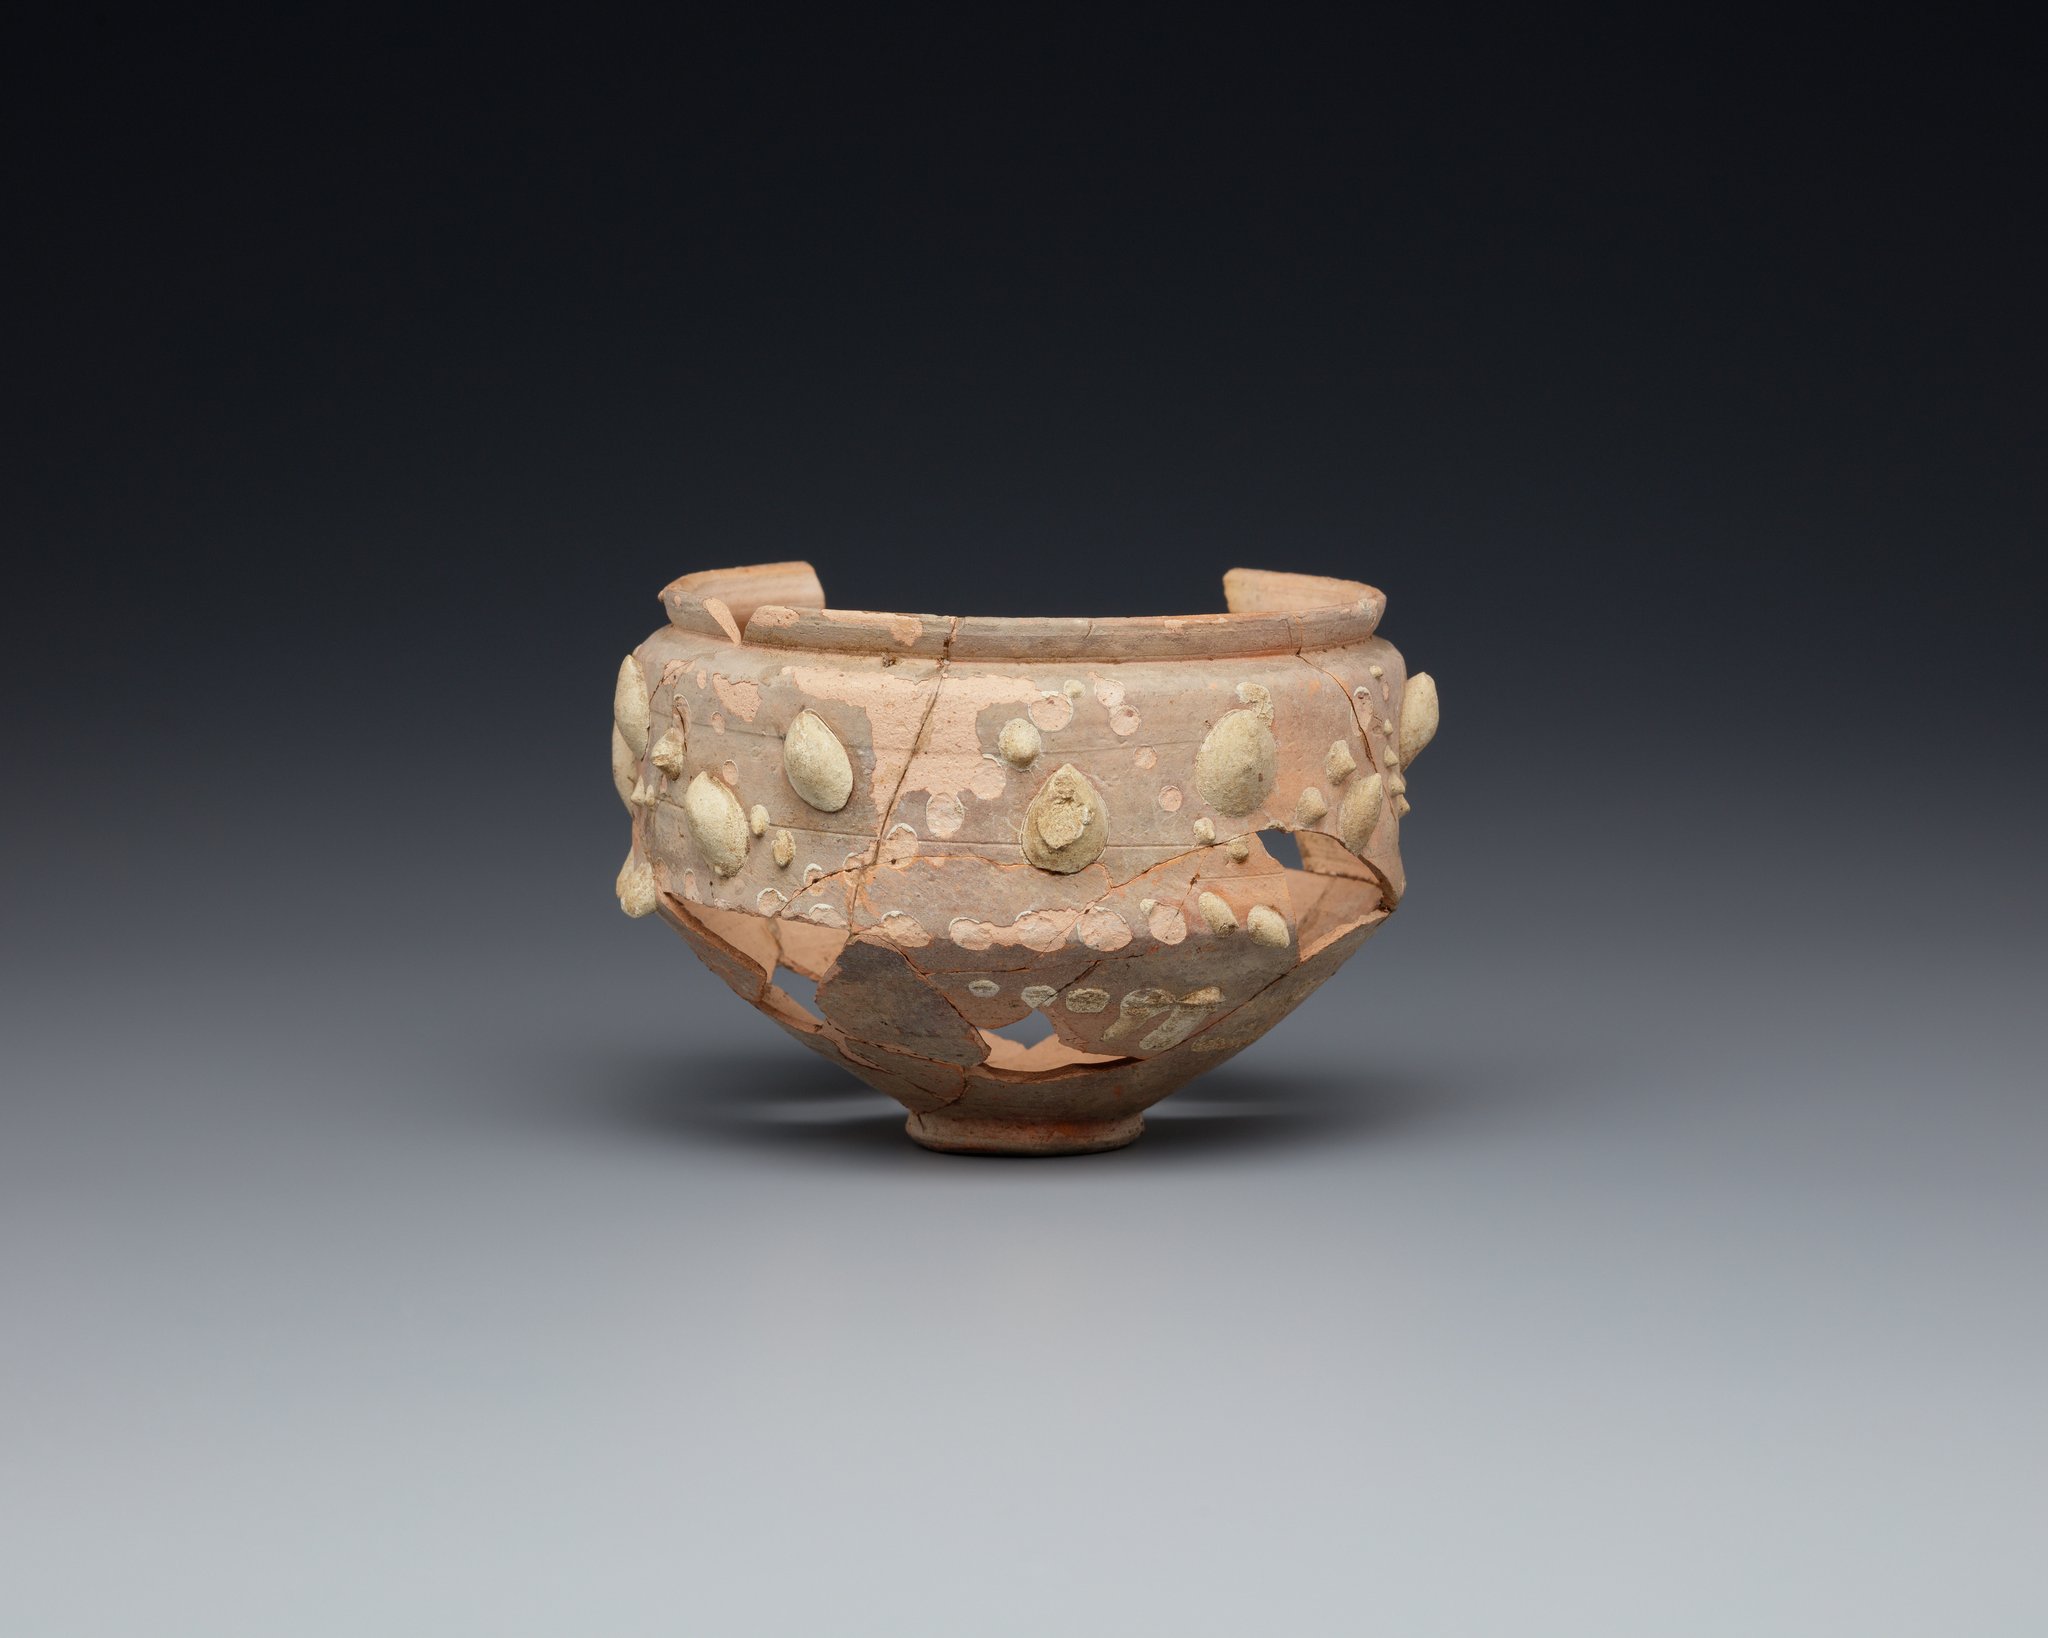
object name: pot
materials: pottery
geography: nubia